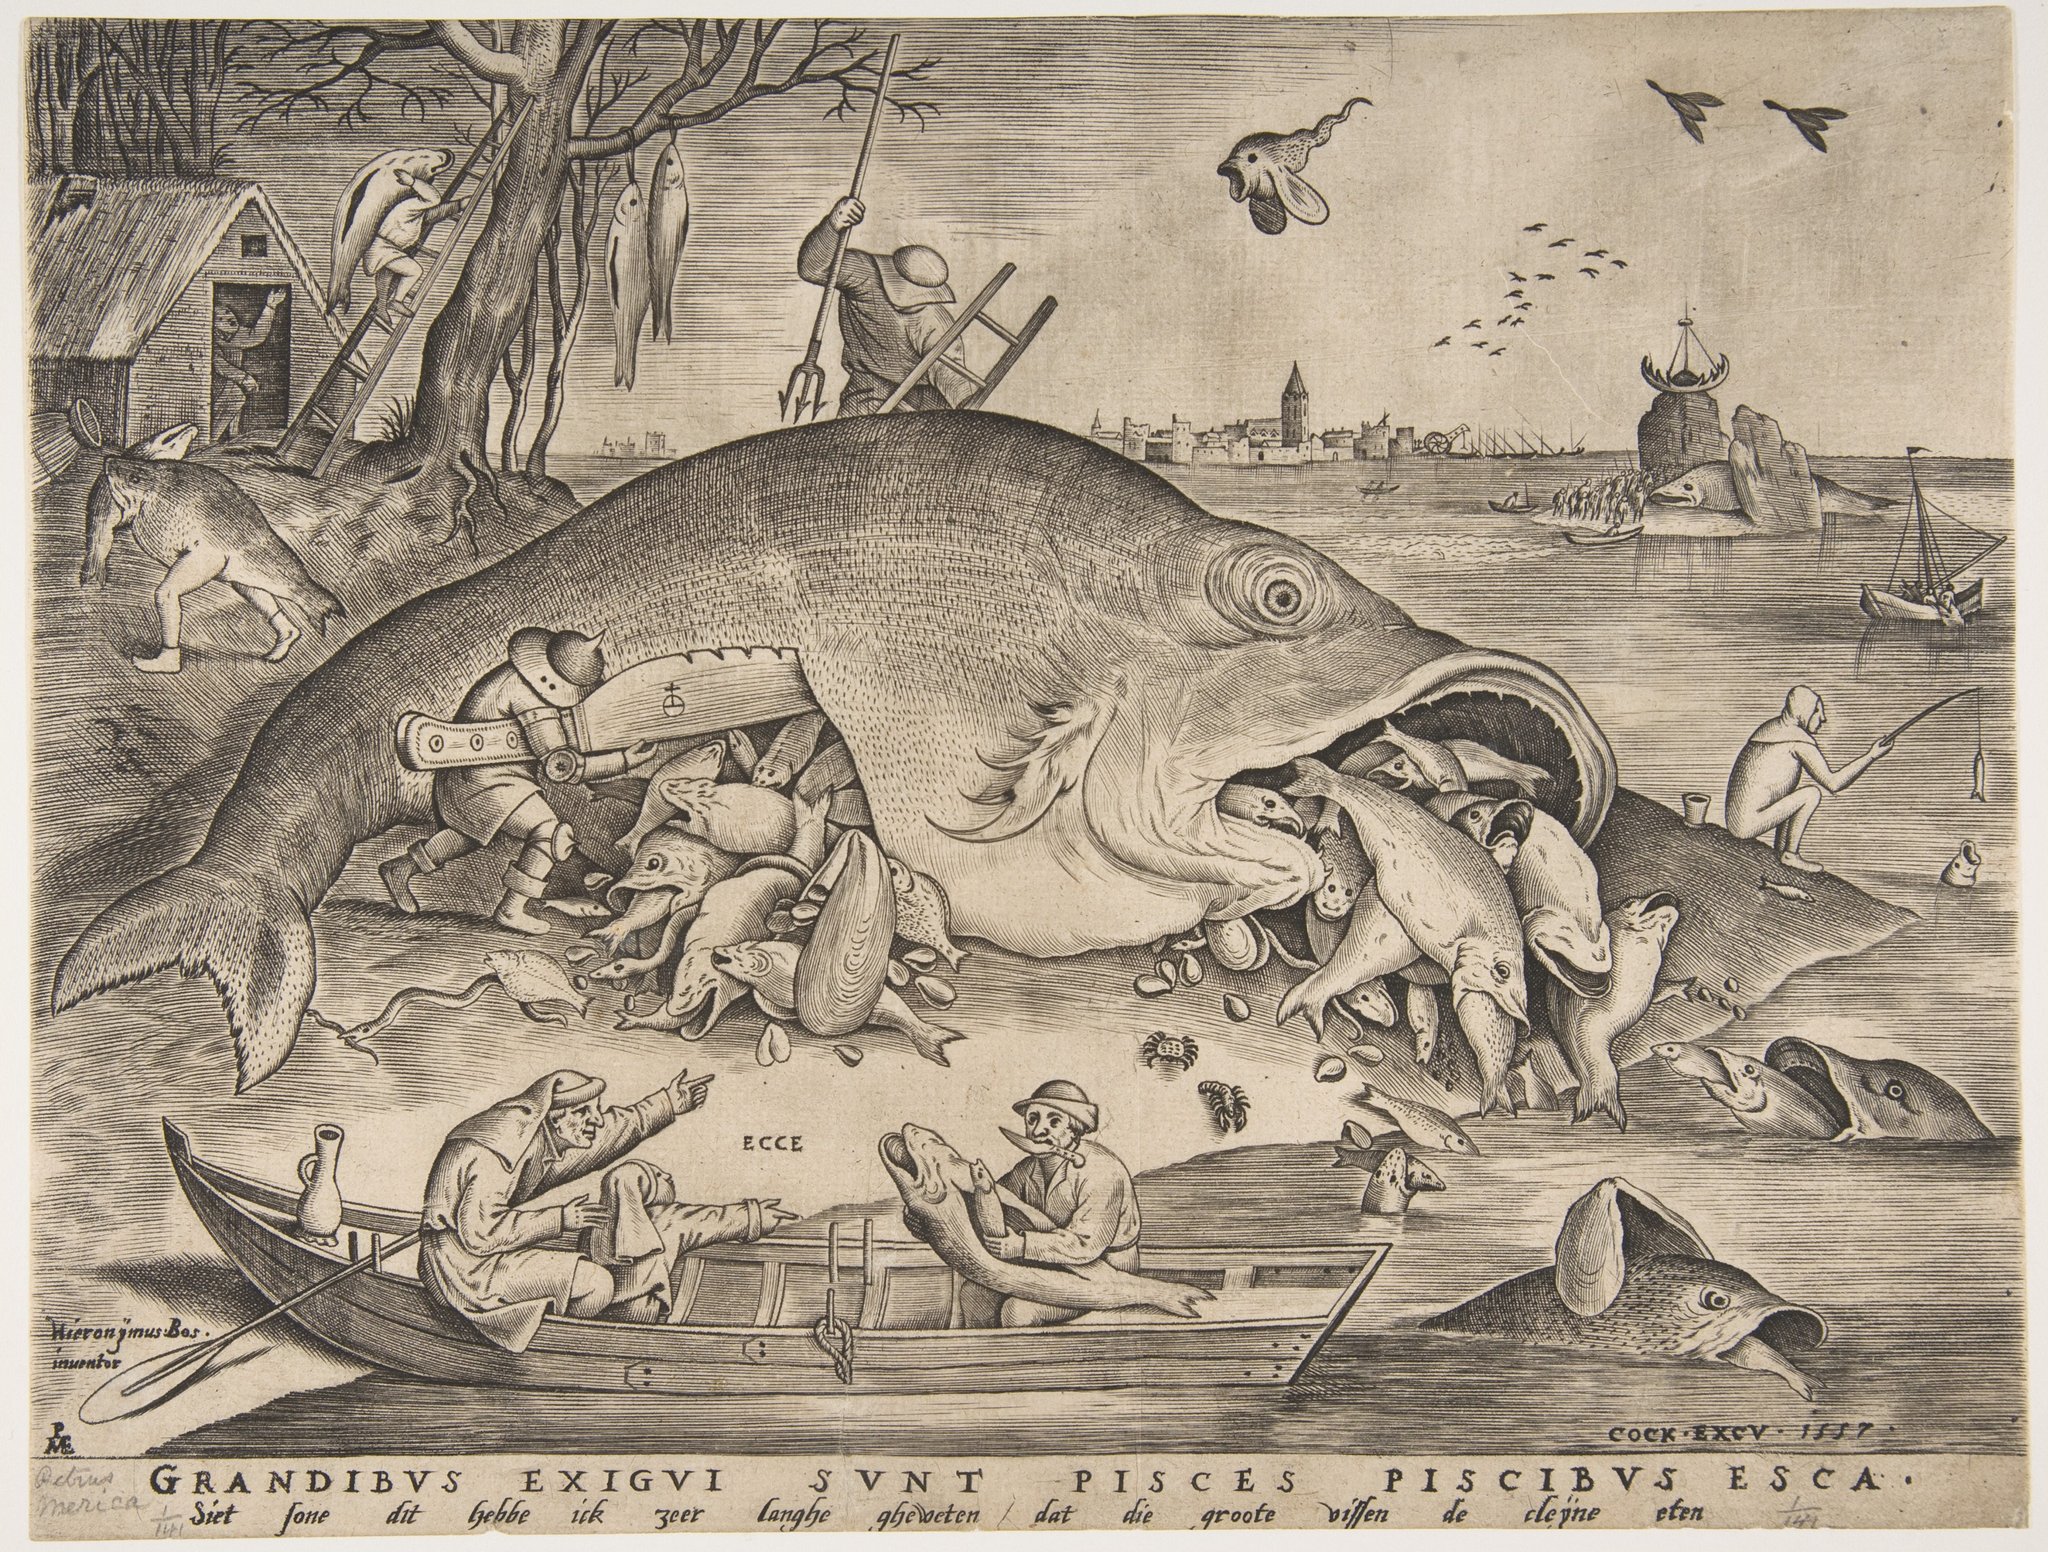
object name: print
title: Big Fish Eat Little Fish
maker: pieter van der heyden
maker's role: artist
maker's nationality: netherlandish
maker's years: 1525-1569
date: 1557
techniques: engraving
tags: fishing,fish,boats